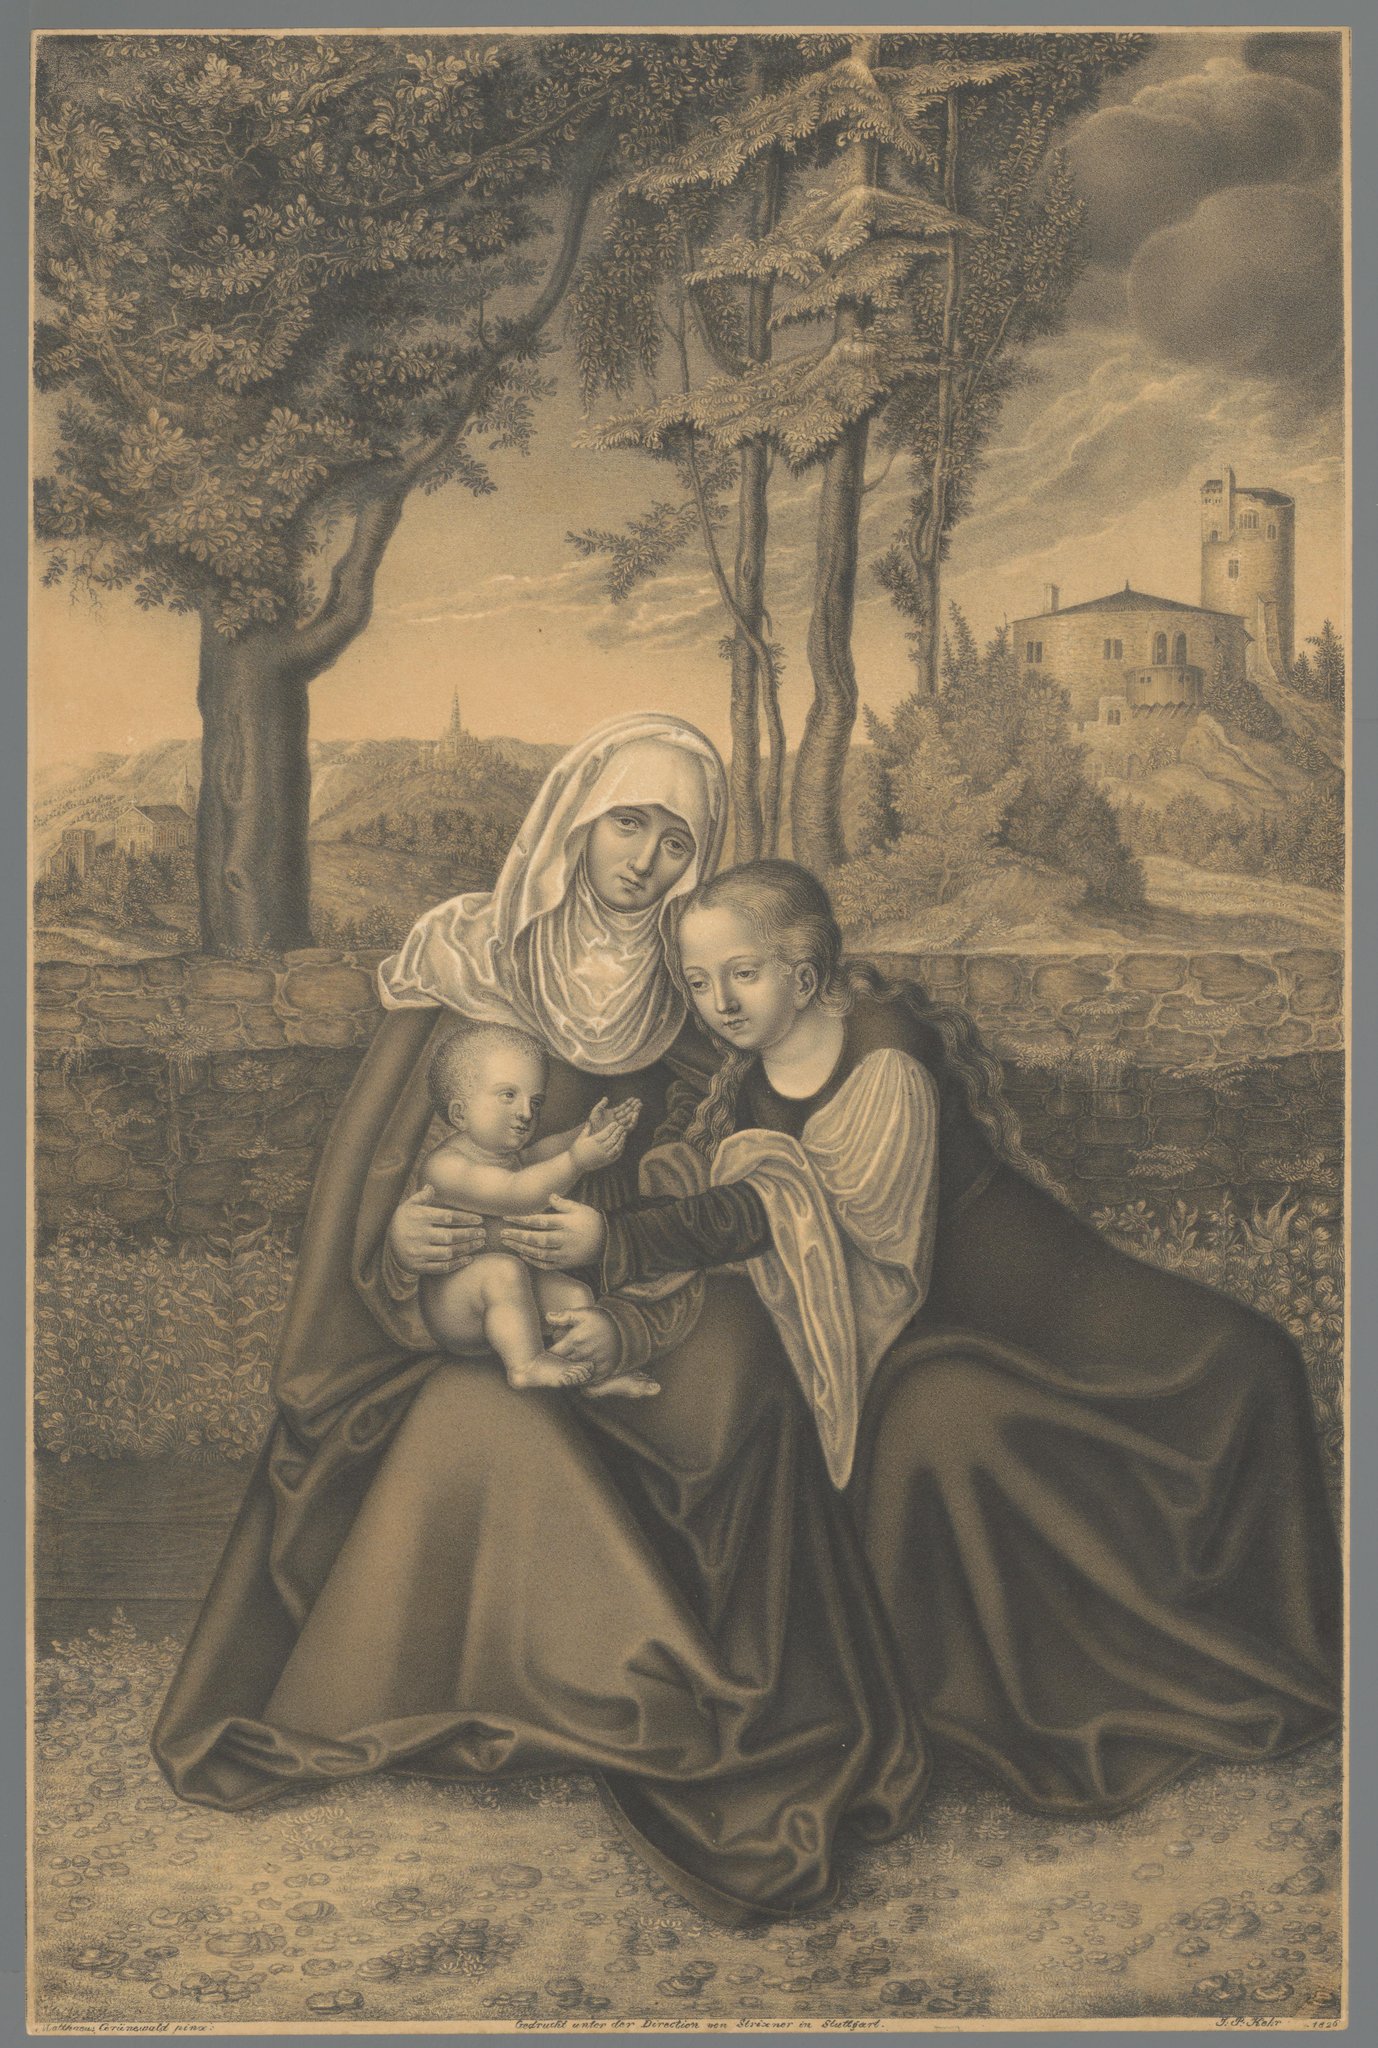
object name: print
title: Anna, Maria en het Christuskind in een landschap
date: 1826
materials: paper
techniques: lithograph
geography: stuttgart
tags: landscapes in the temperate zone, anna, mother of mary; possible attributes: book, christ-child, lily, virgin mary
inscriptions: collector's mark: Lugt 2228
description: Linksonder op de prent staat dat het gemaakt is naar een schilderij van Matthias Grünewald, maar dit is foutief. Het gaat om een werk van Lucas Cranach. Deze prent behoort waarschijnlijk tot de serie 'Galerie des Frères Boisserée'.